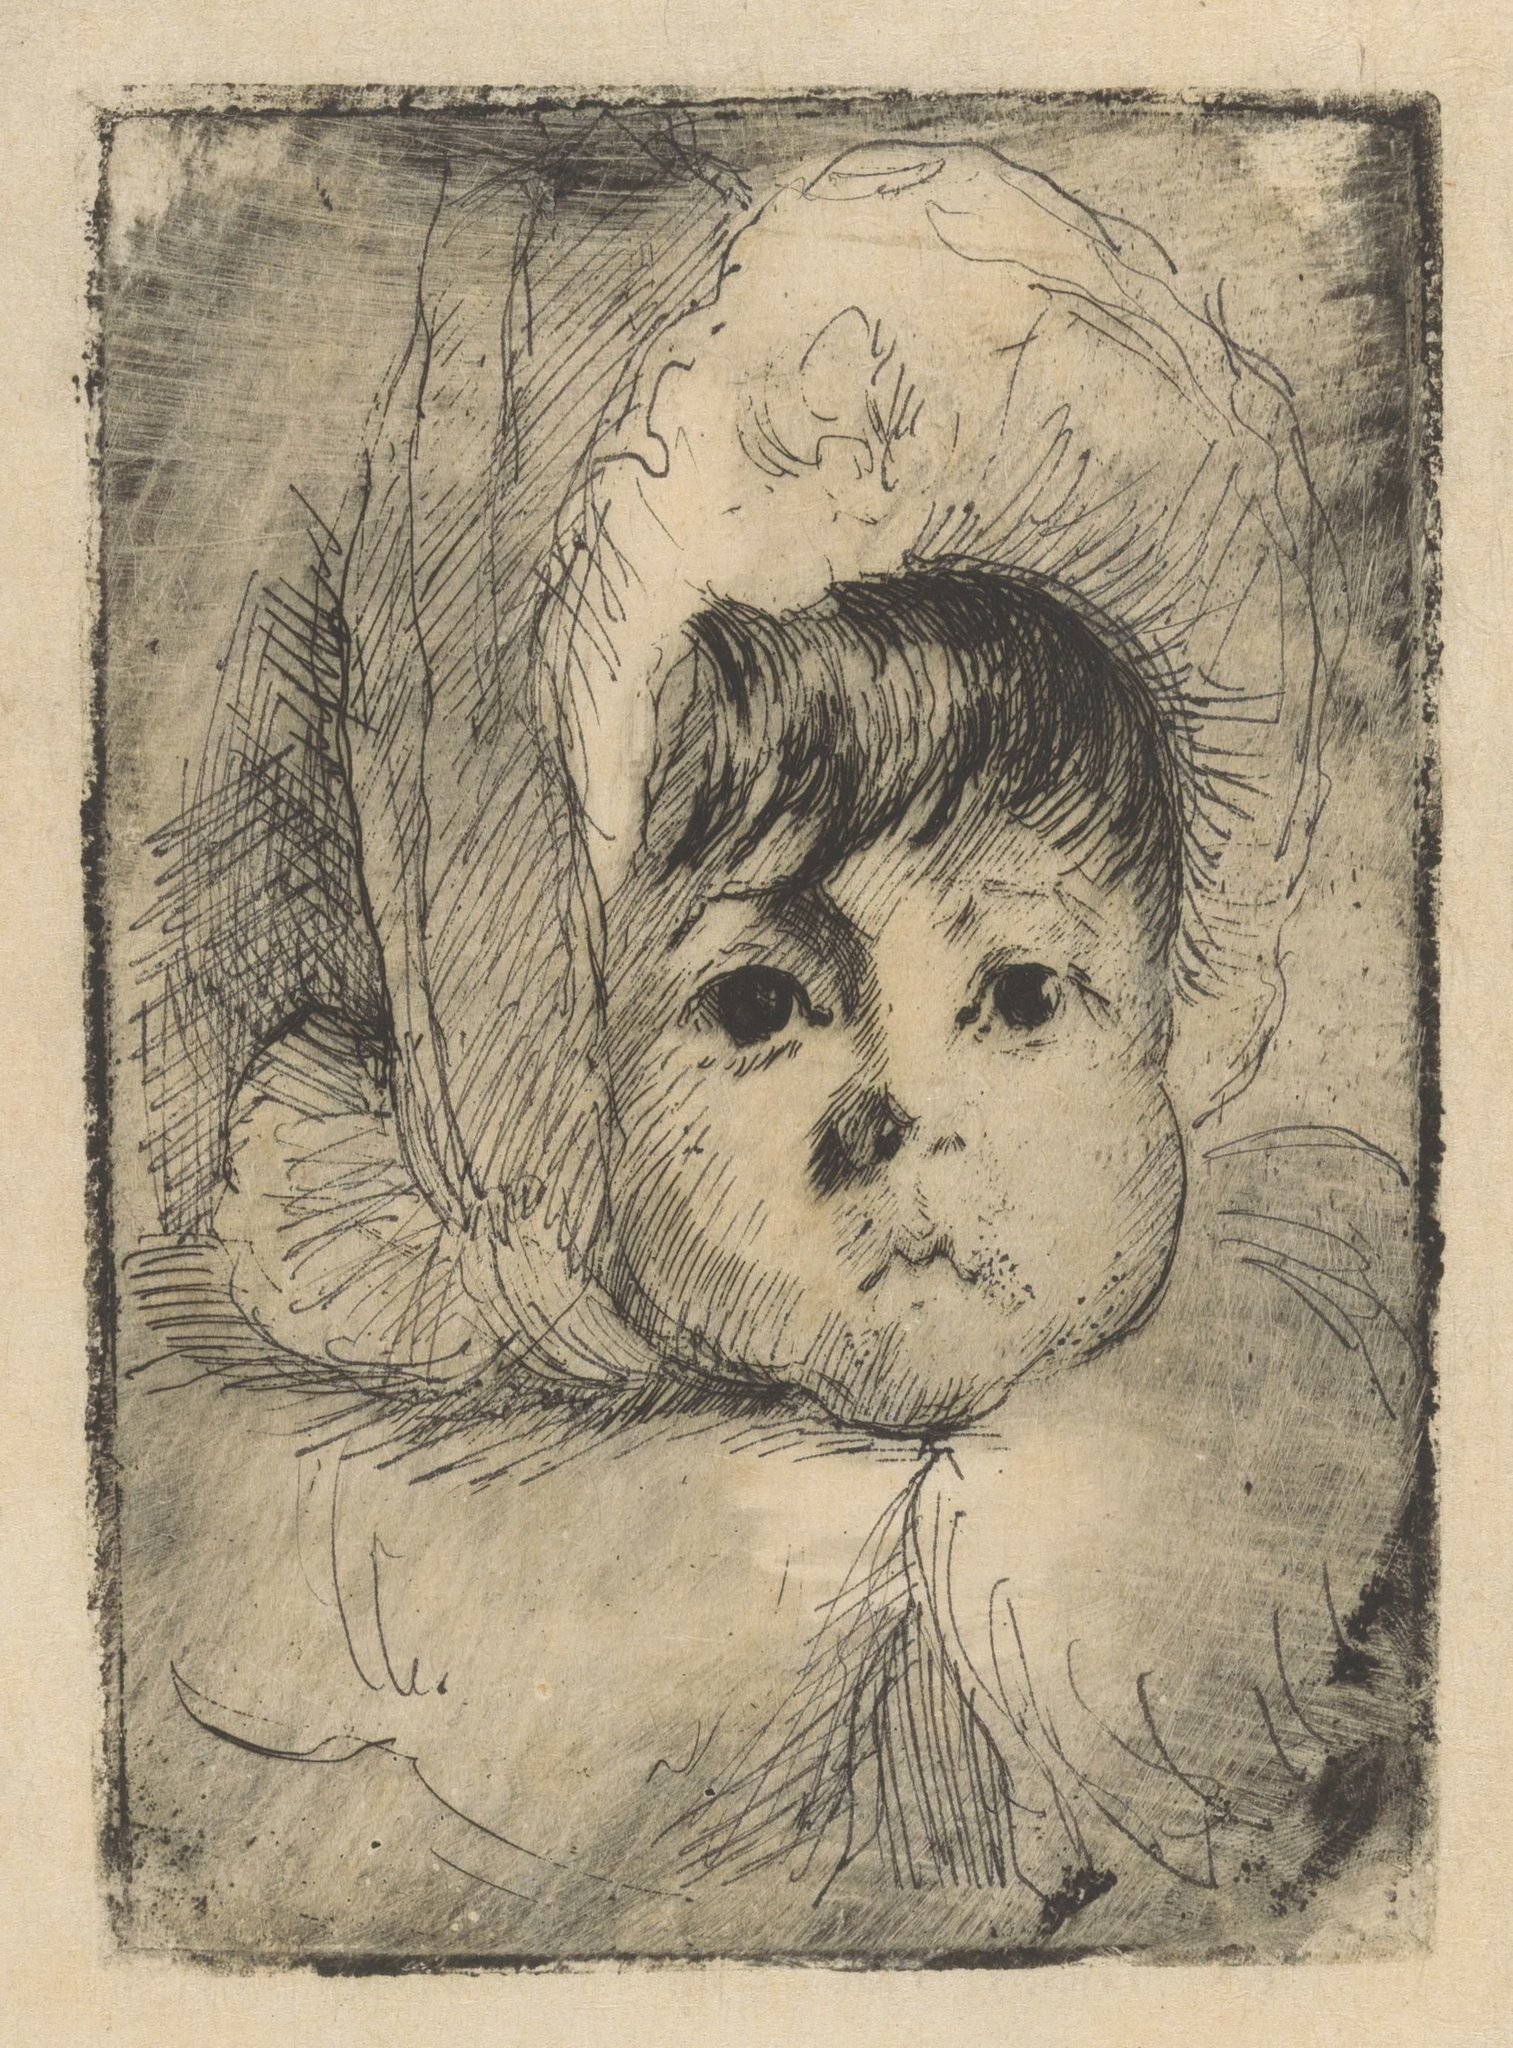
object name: print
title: Portret van Elizabeth Mouton als kind met kap op het hoofd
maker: barbara elisabeth van houten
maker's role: draughtsman, print maker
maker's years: 1862-1950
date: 1877-1950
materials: paper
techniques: etching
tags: female infant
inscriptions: collector's mark: Lugt 2228